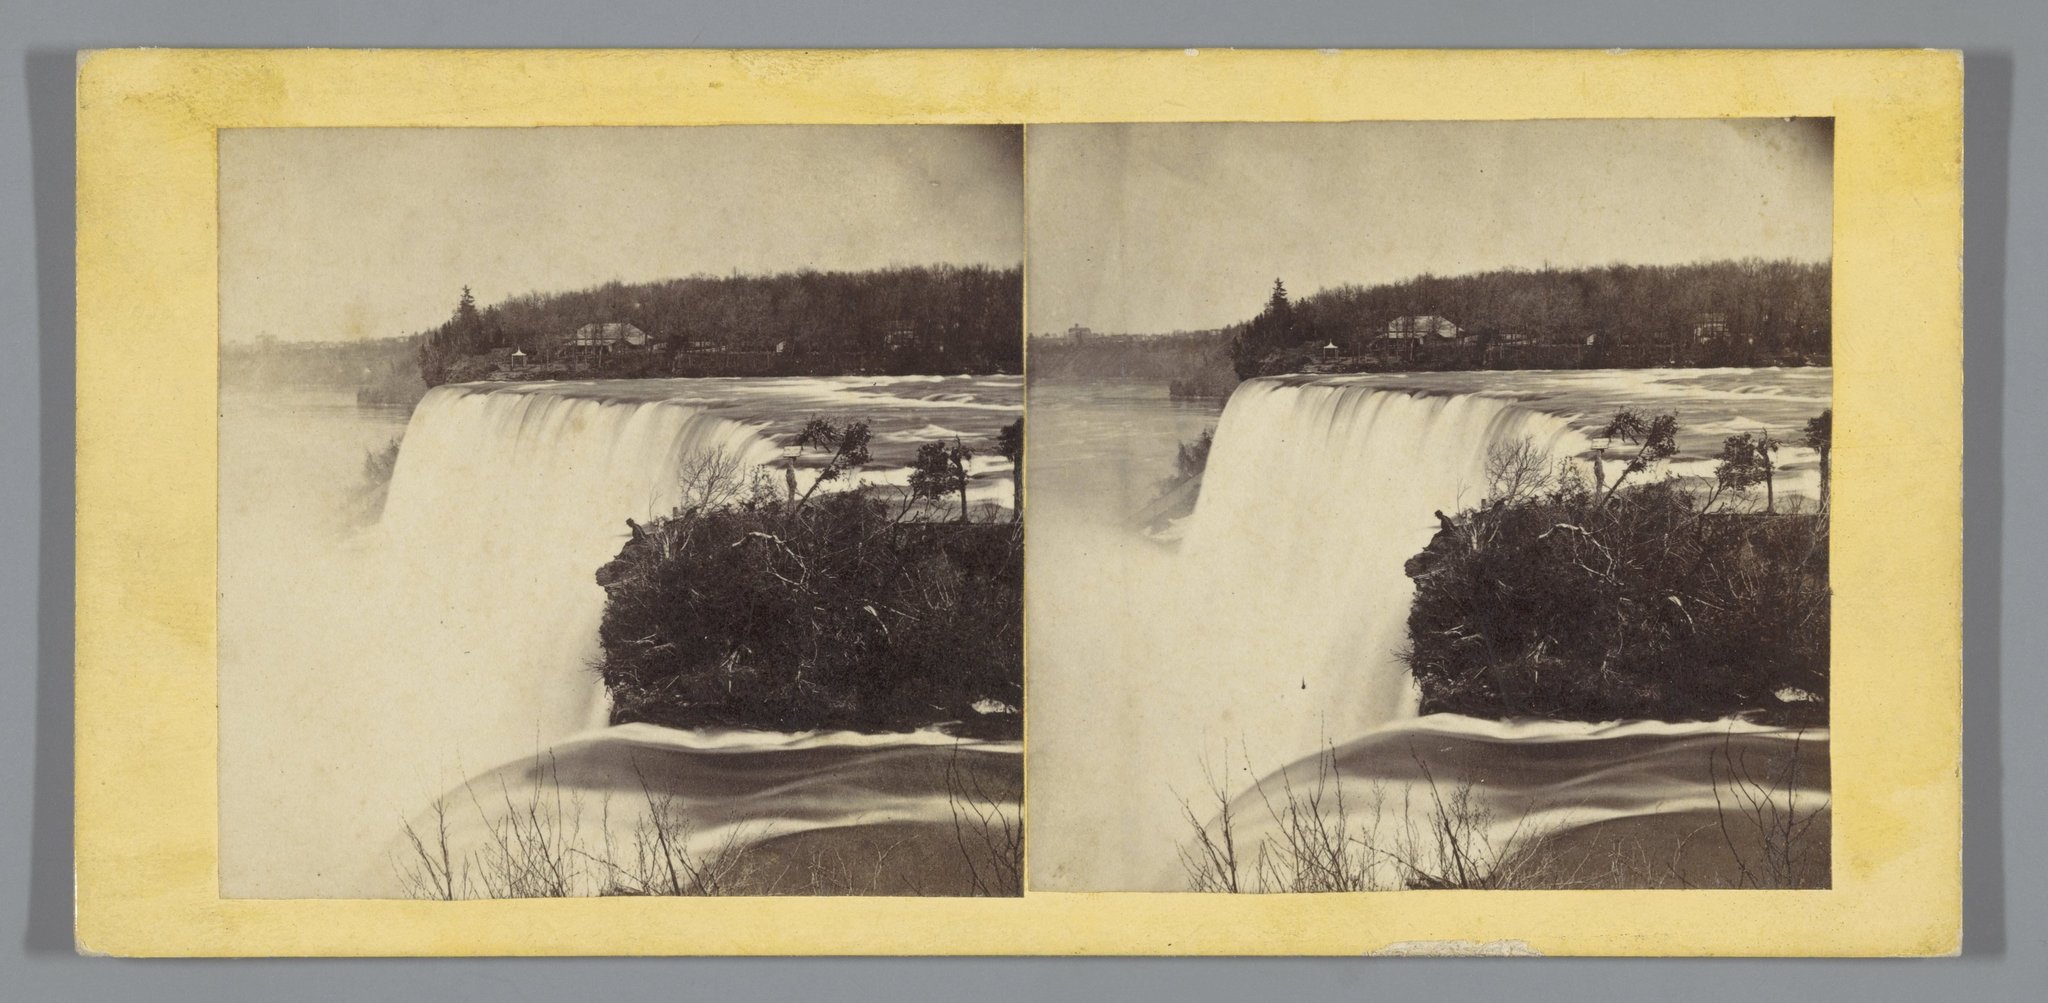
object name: stereograph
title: Niagara Falls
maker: Anonymous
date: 1861-1870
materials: cardboard, paper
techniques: albumen print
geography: niagara falls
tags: waterfall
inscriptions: title: ‘Niagara Falls’